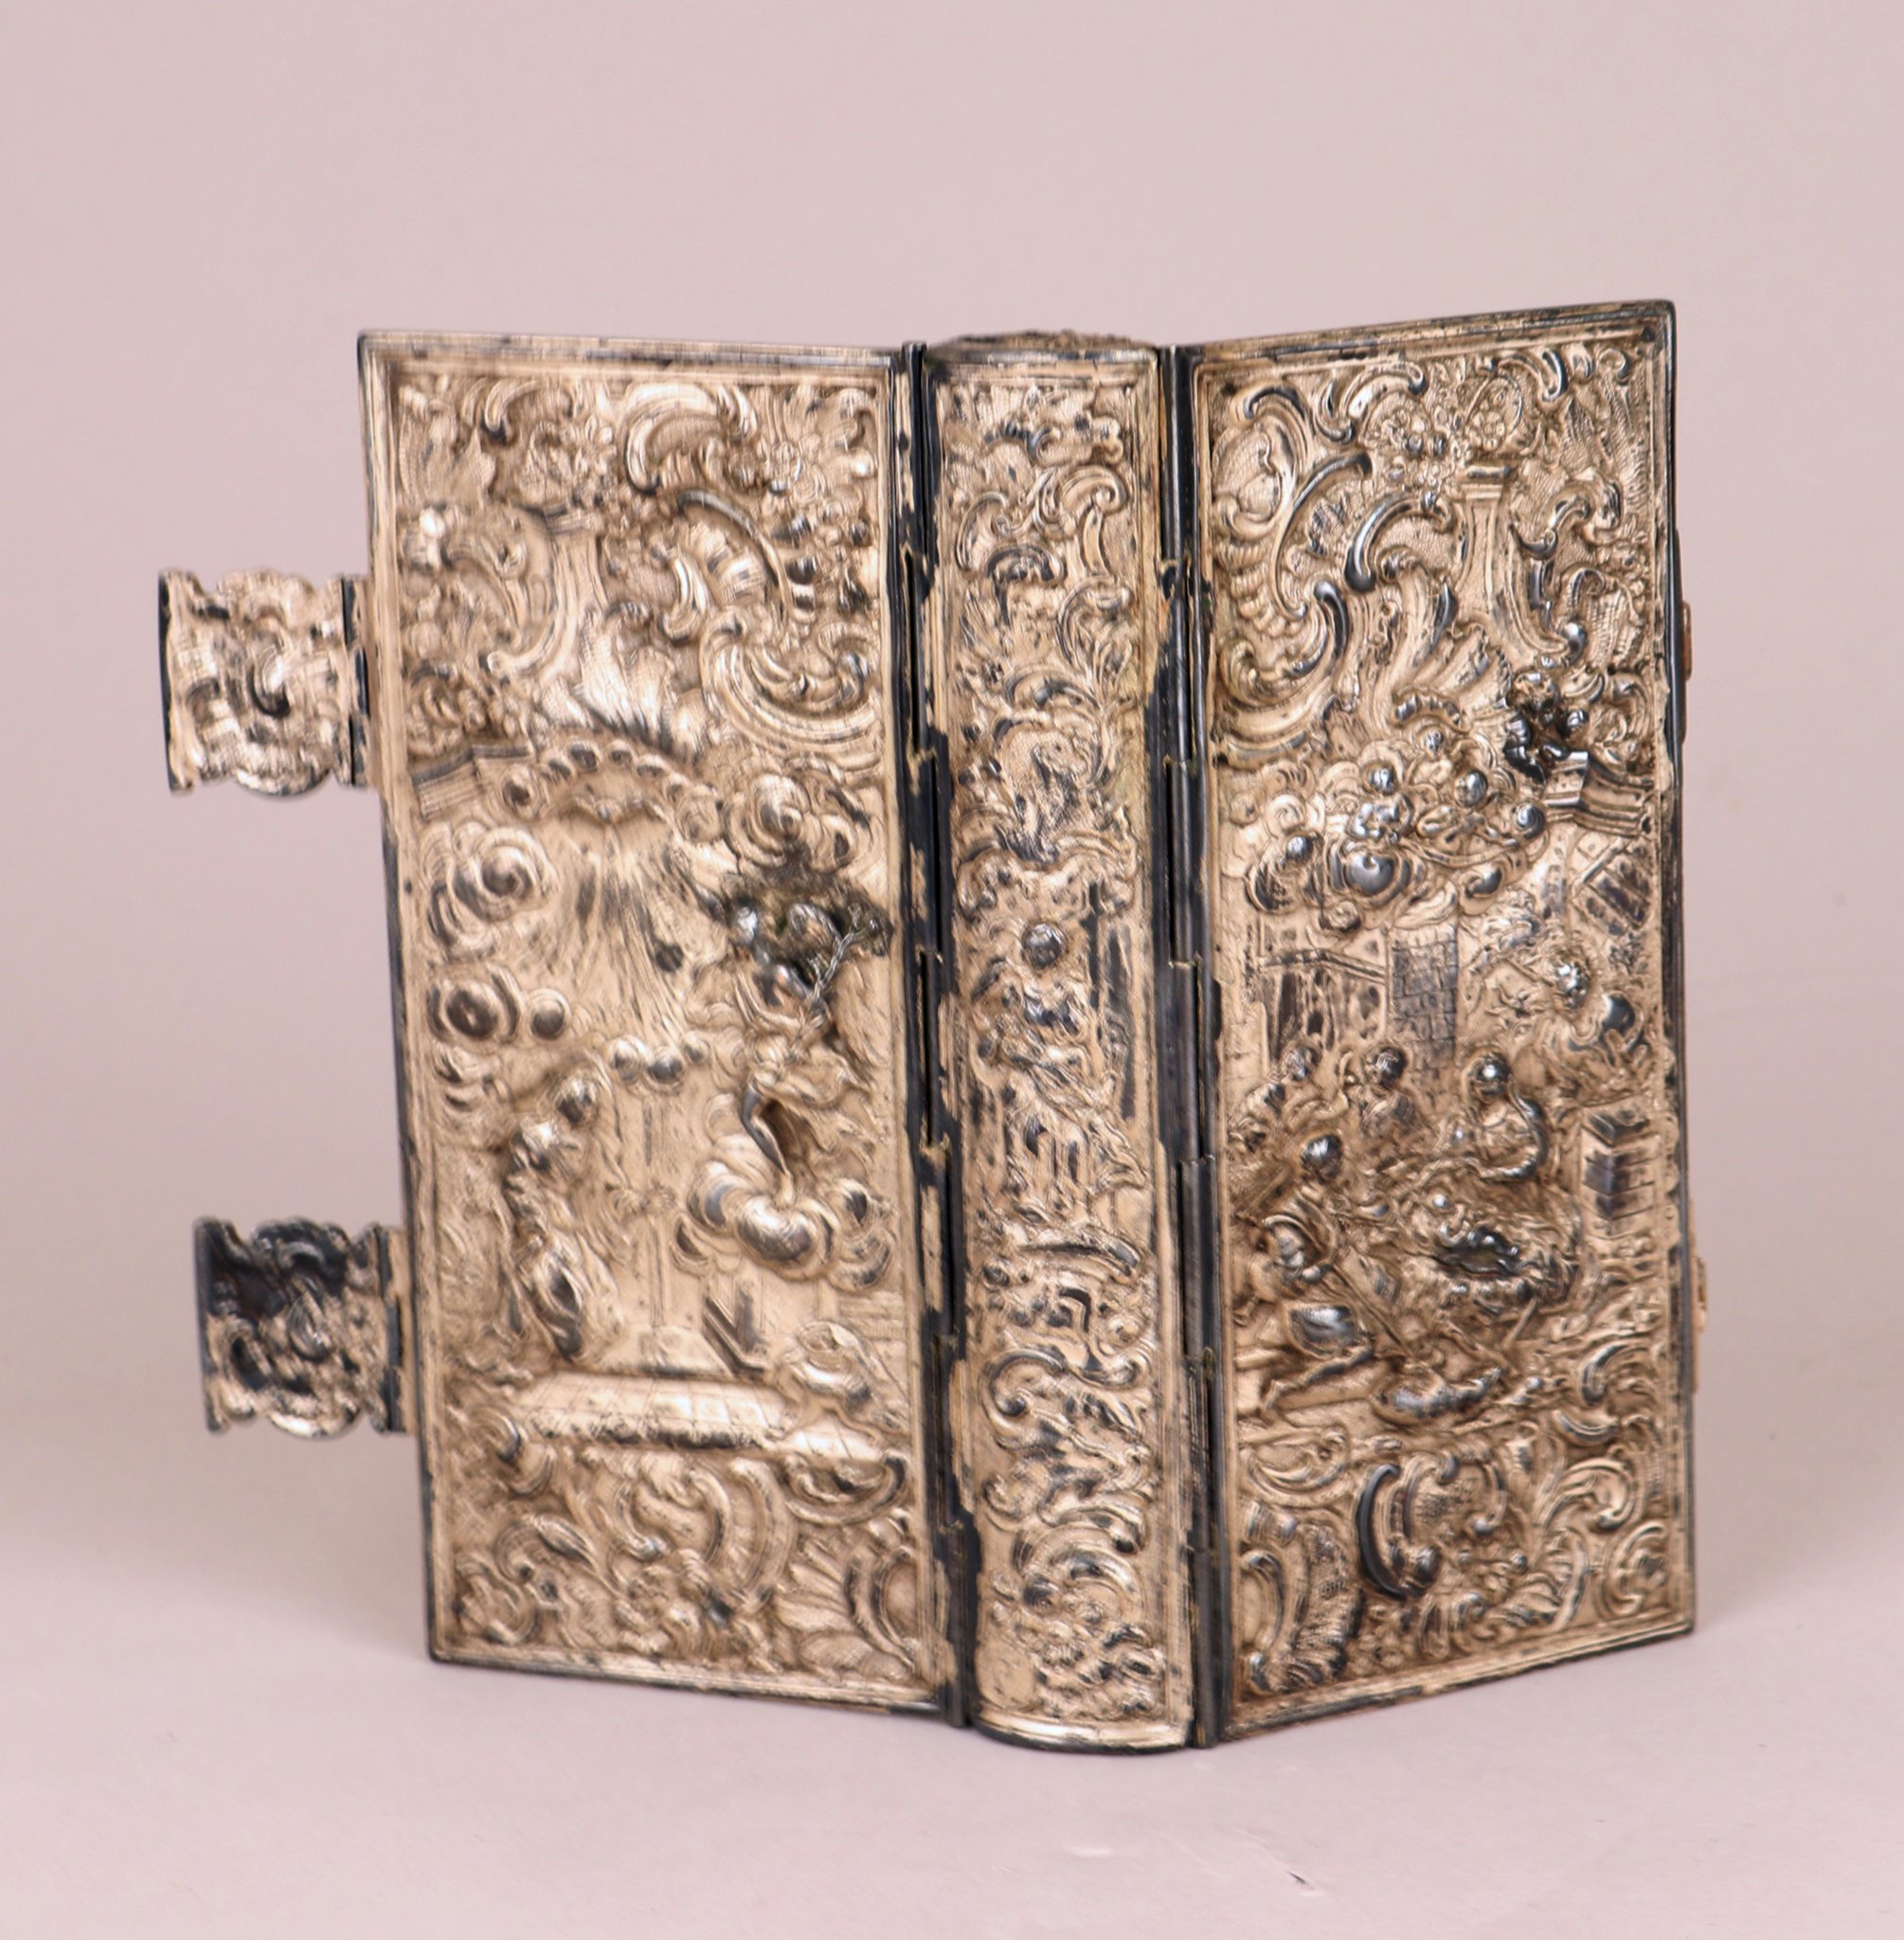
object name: book cover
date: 1801-1900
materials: metal, silver